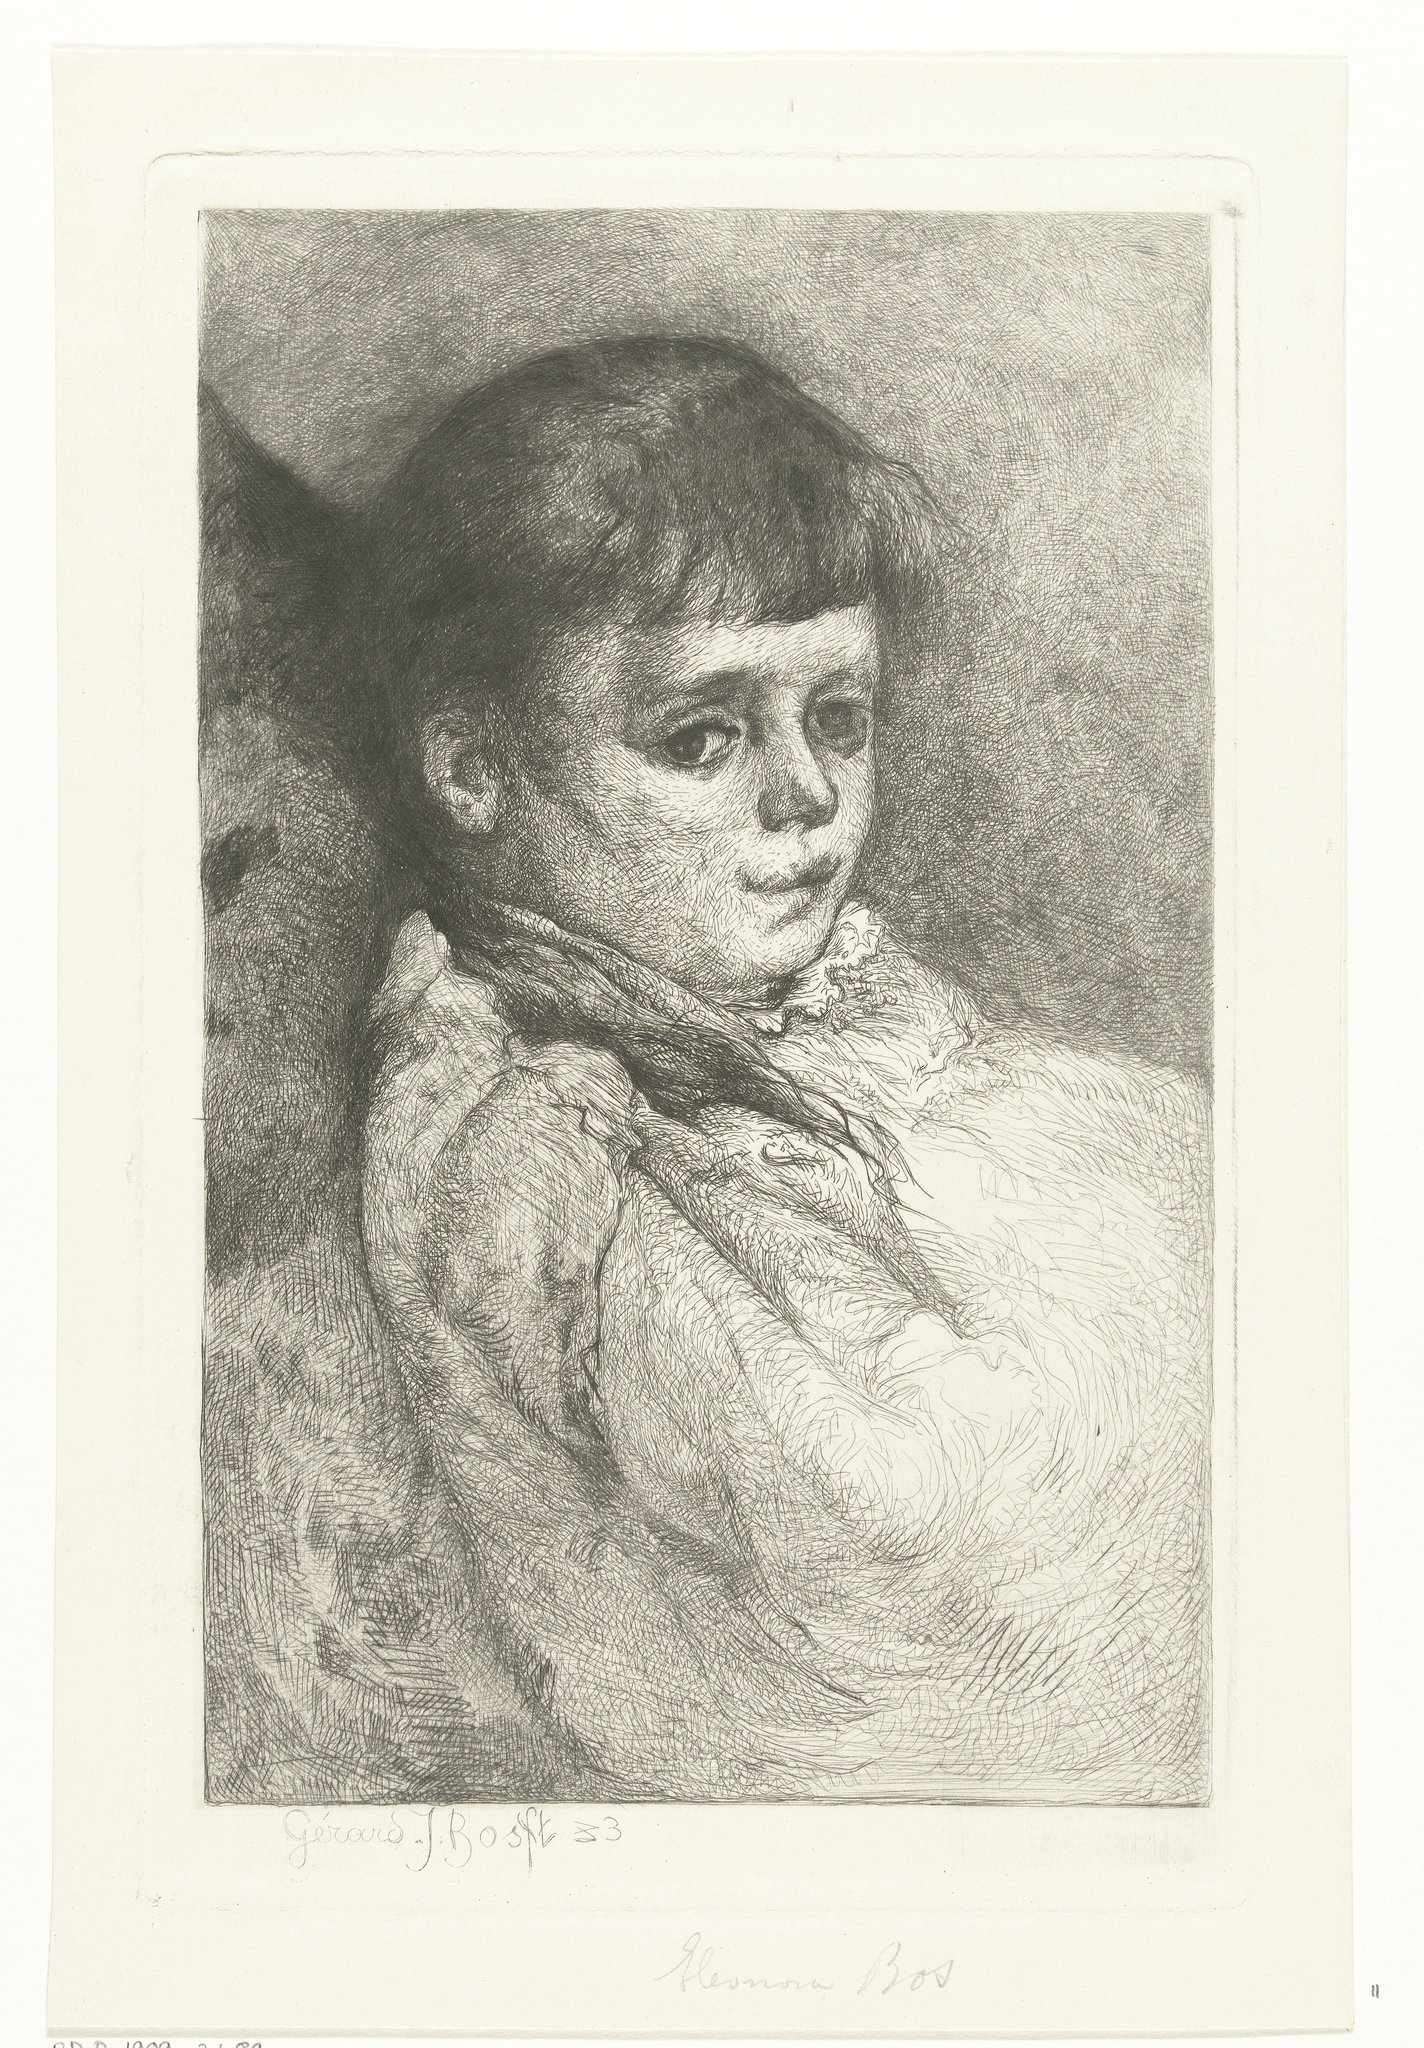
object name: print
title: Portret van Eleonora Bos met poes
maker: gerard jan bos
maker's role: print maker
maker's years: 1860-1943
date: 1883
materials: paper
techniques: drypoint, etching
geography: antwerp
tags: eleonora bos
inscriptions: collector's mark: Lugt 2228